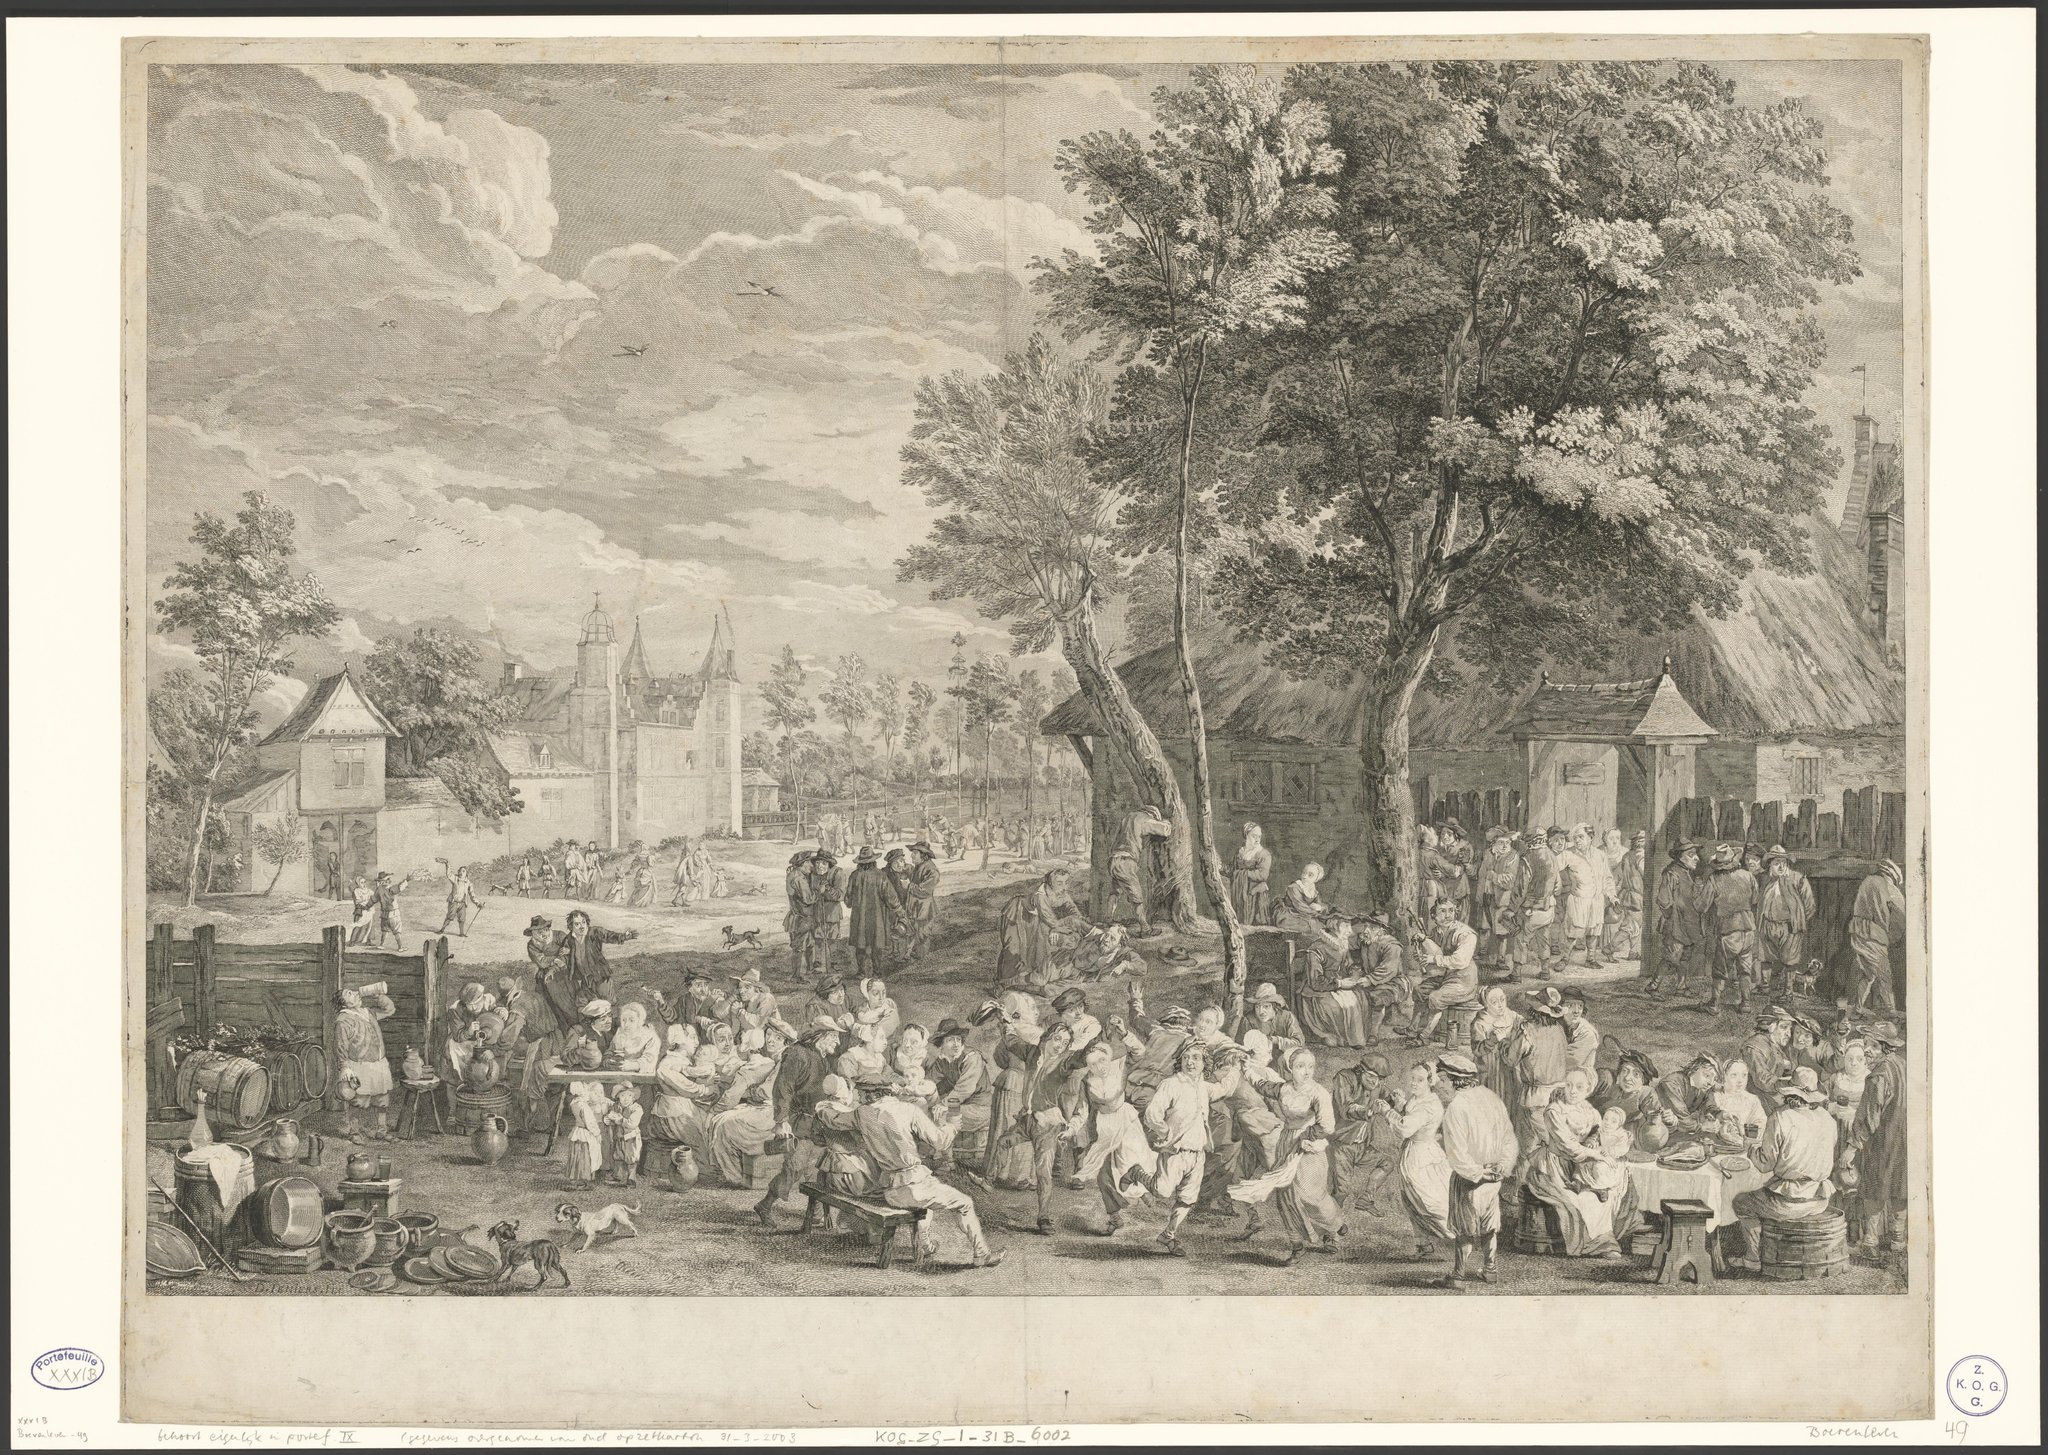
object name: print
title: Dorpsfeest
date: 1751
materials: paper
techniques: etching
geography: france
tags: public festivities, village square, place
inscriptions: collector's mark, collector's mark: Lugt 1641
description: Dorpsfeest. Vóór het onderschrift en de titel '4me. Fête Flamande'. Onderwerpsrubrieken binnen de Atlas Zeden en Gewoonten: Boerenleven; prenten van bijzonder groot formaat.